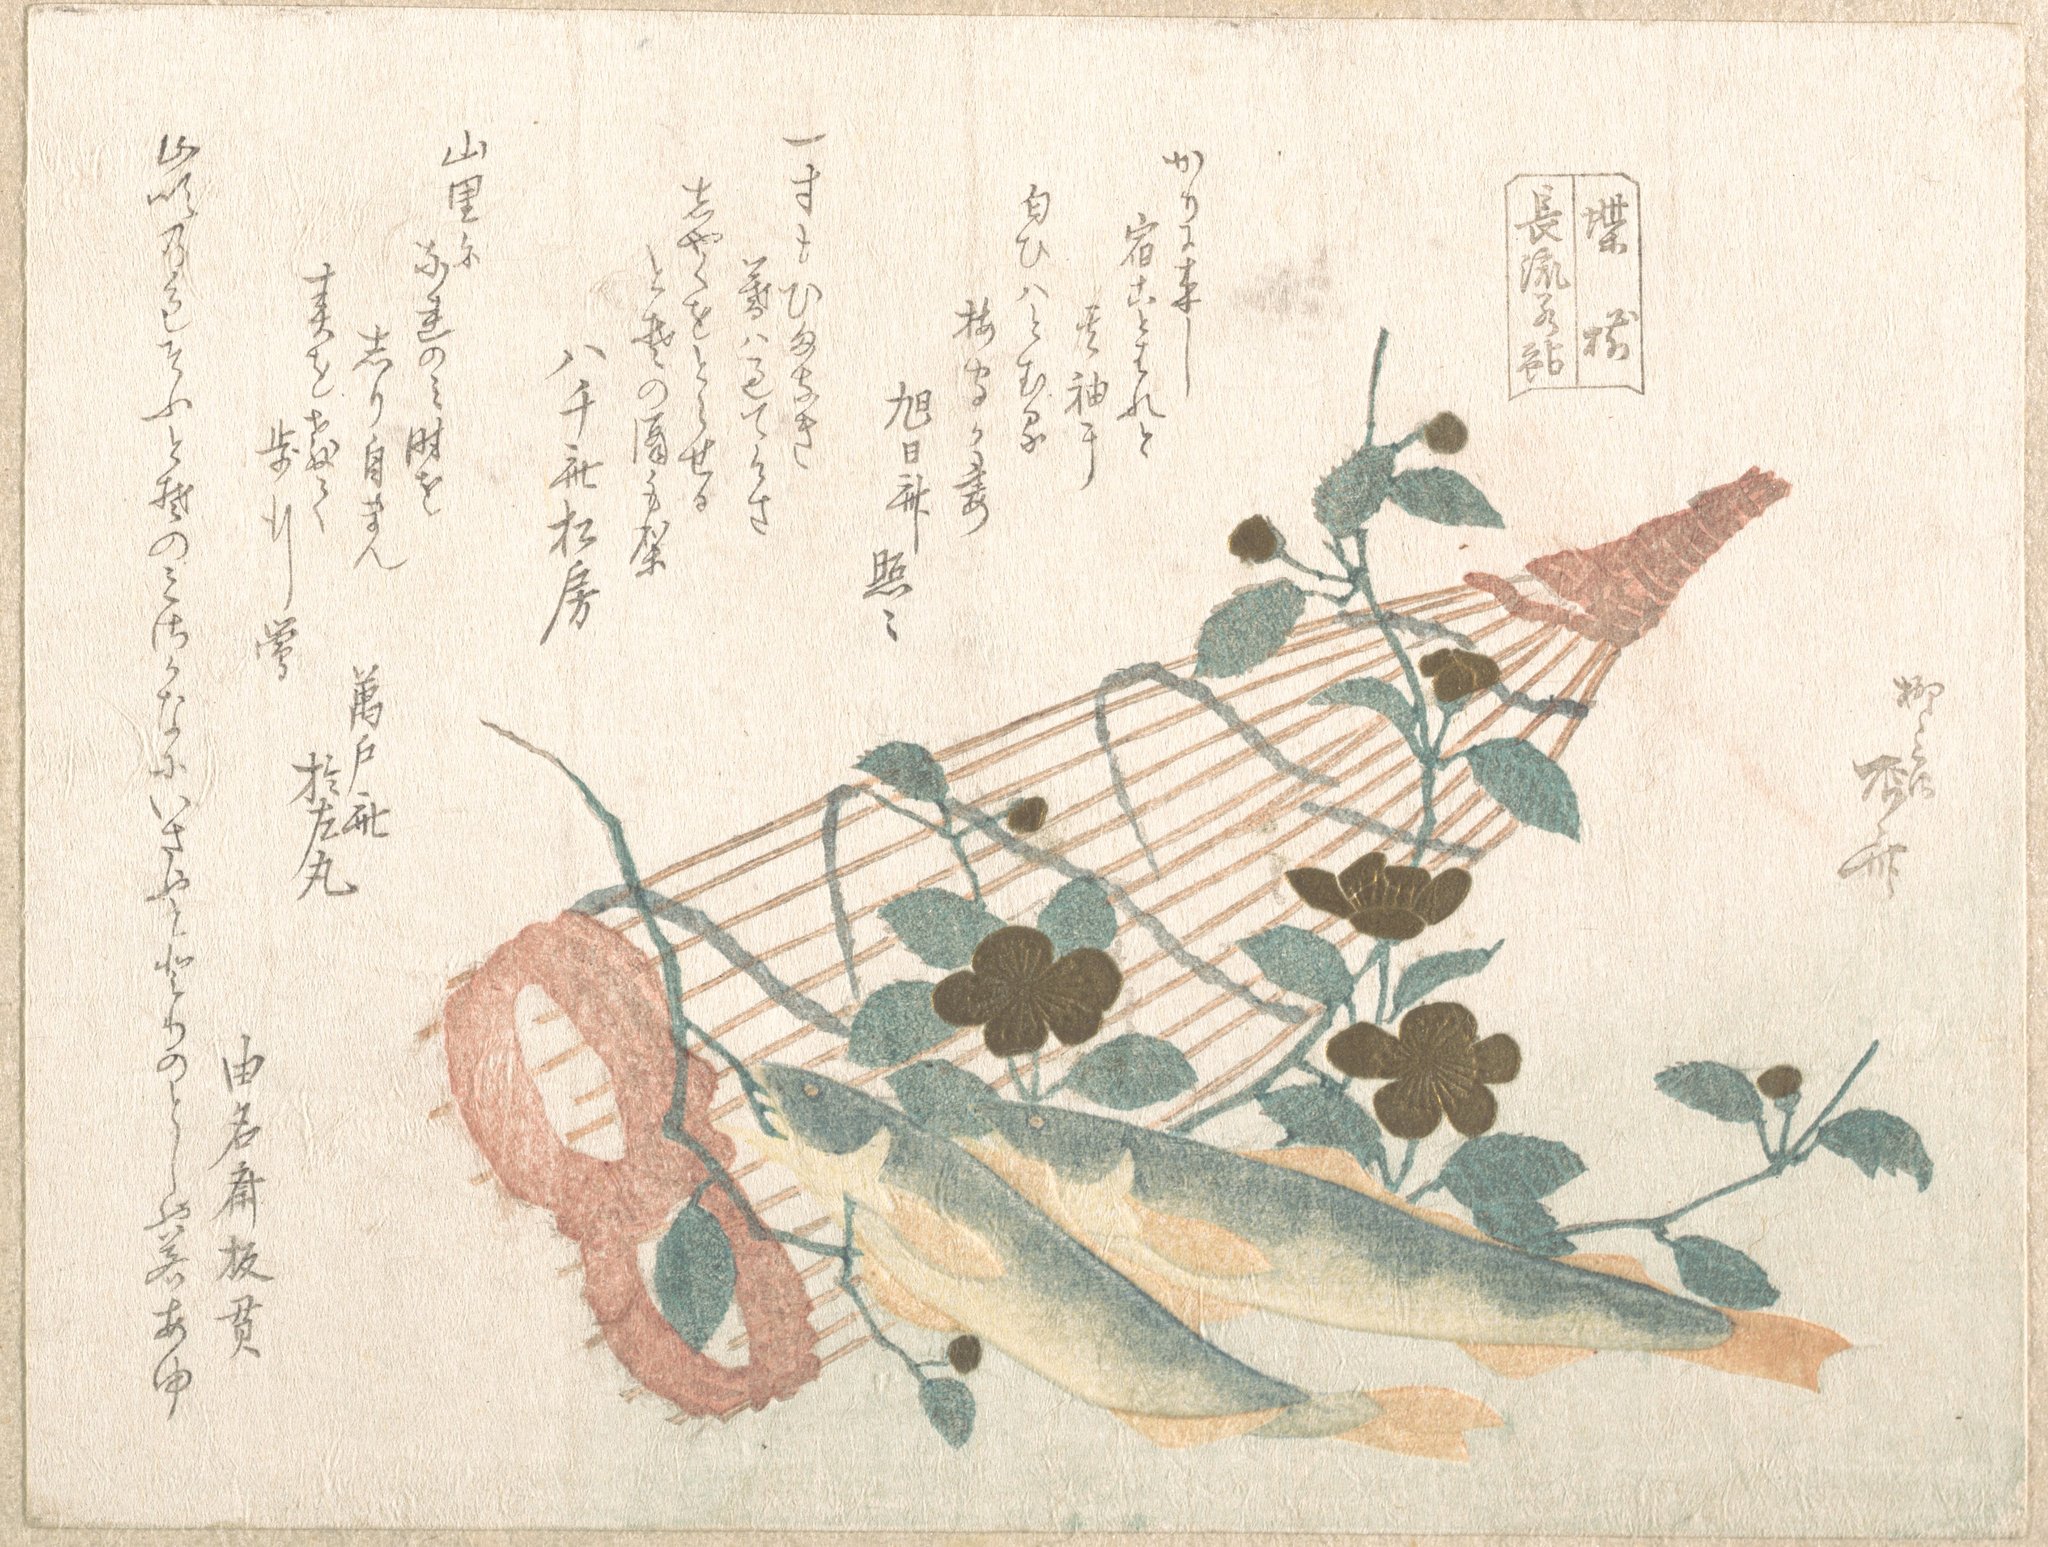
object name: woodblock print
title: Sweet Fishes of the Nagara River, with Baskets and Flowers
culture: japanese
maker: ryūryūkyo shinsai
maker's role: artist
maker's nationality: japanese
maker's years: 1799-1823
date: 1801-1900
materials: ink, paper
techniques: surimono, woodblock print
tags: fish,flowers,baskets